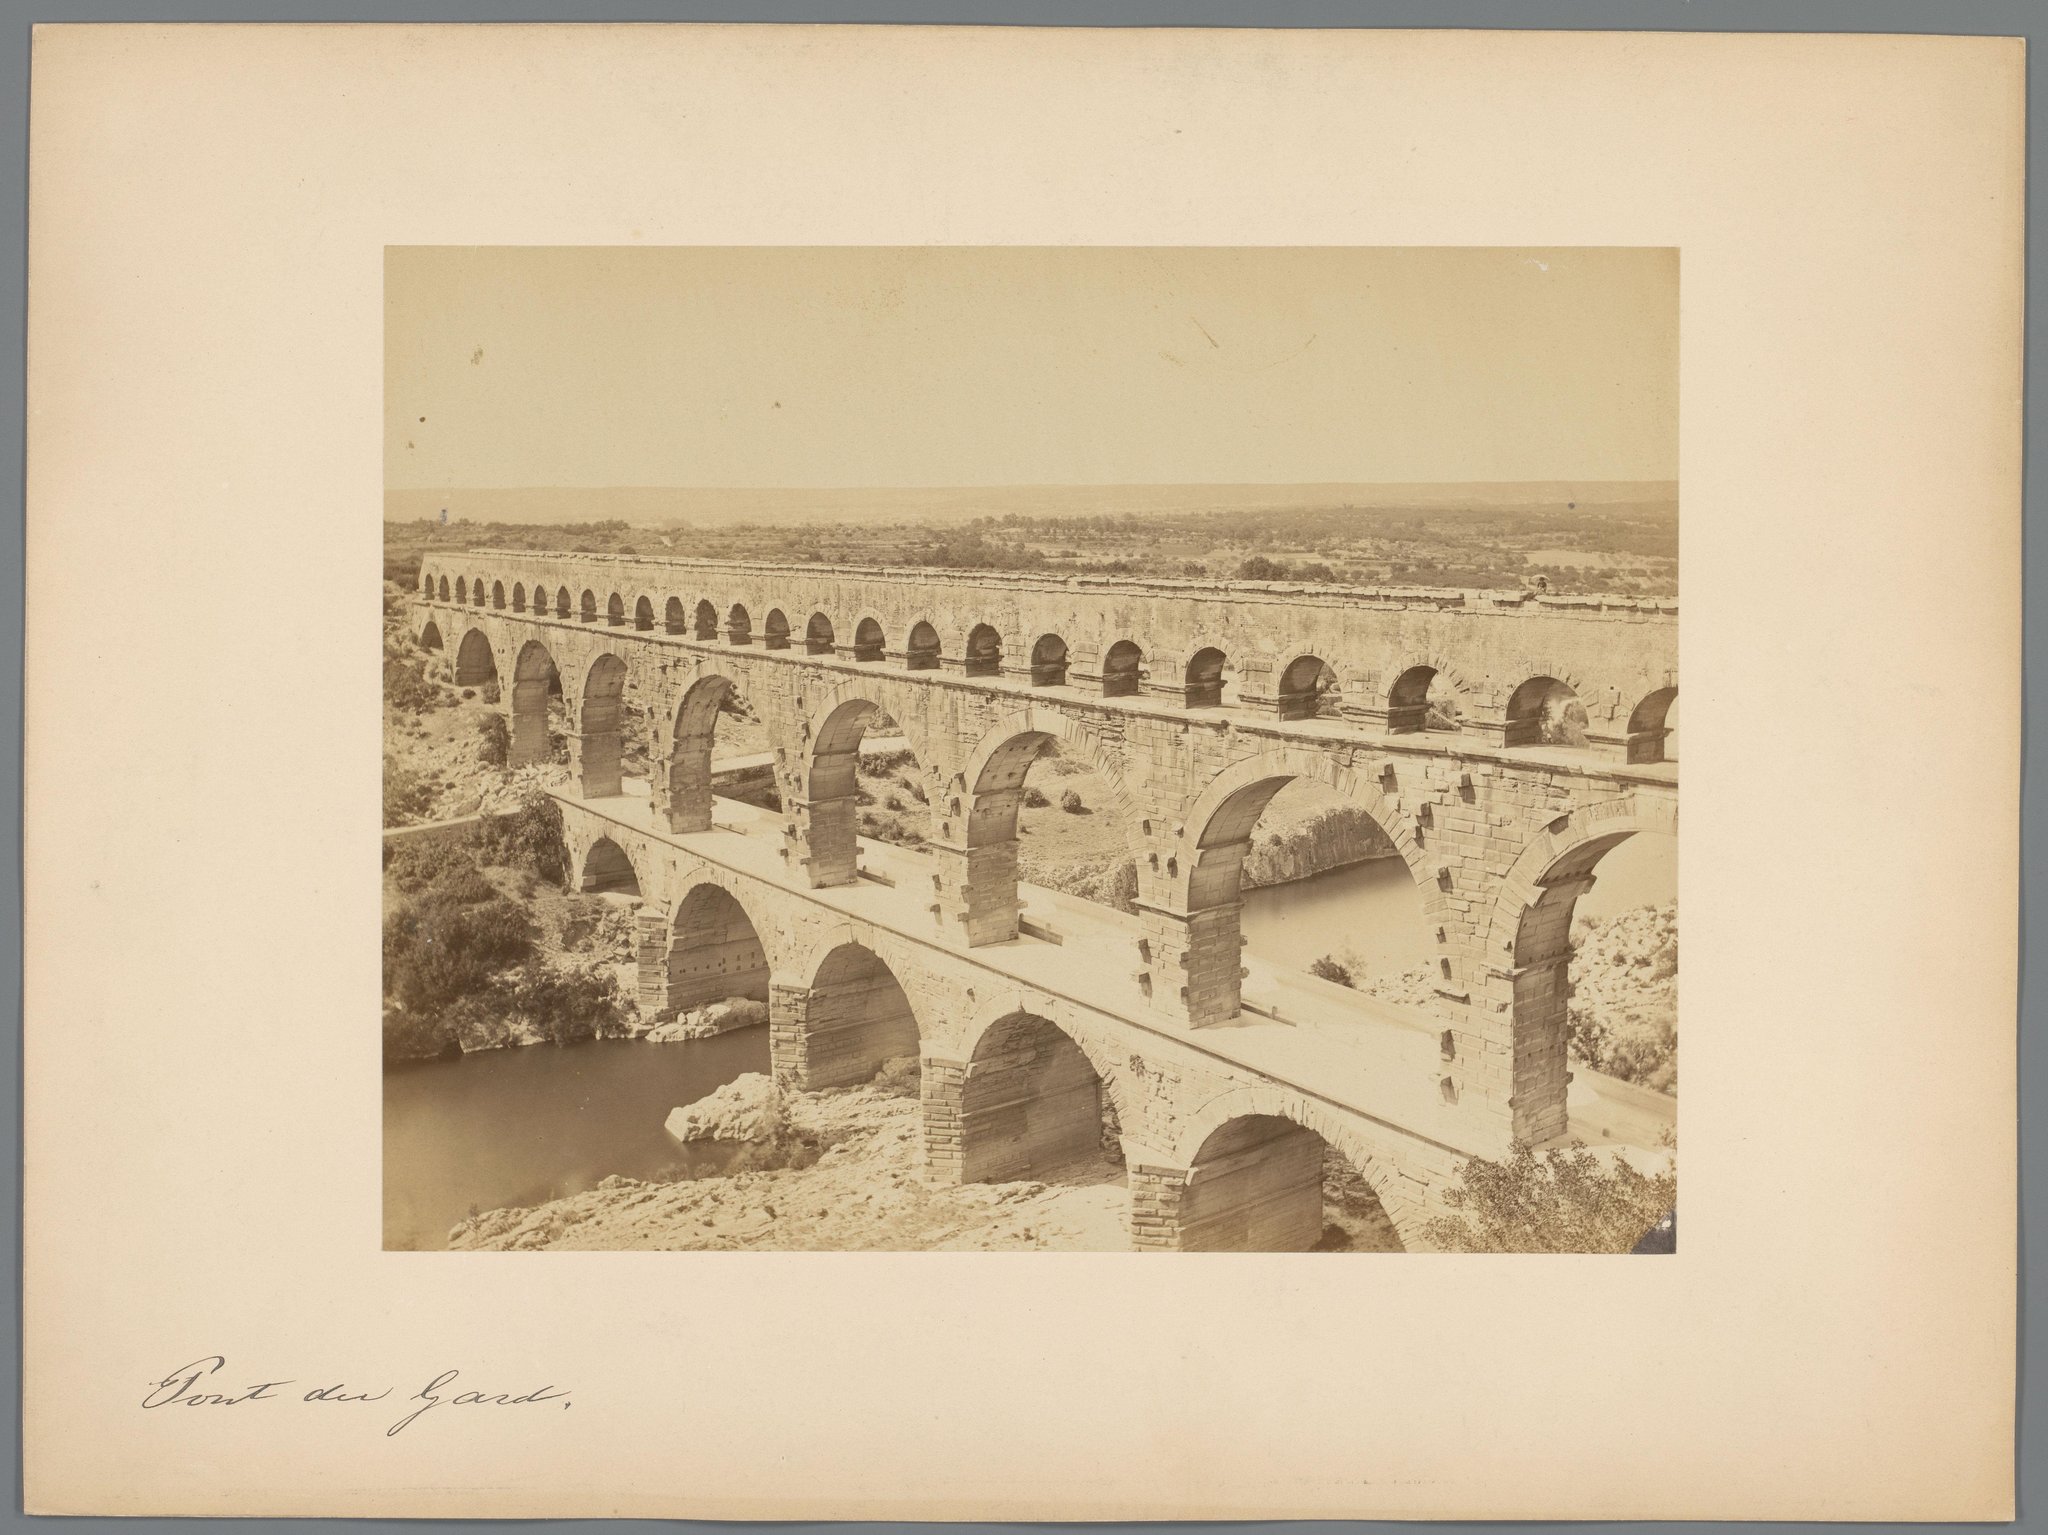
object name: photograph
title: Gezicht op de Pont du Gard, Frankrijk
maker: Anonymous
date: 1870-1900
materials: cardboard, paper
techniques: albumen print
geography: gard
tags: landscape with bridge, viaduct or aqueduct, bridge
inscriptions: collector's mark: Lugt 2228